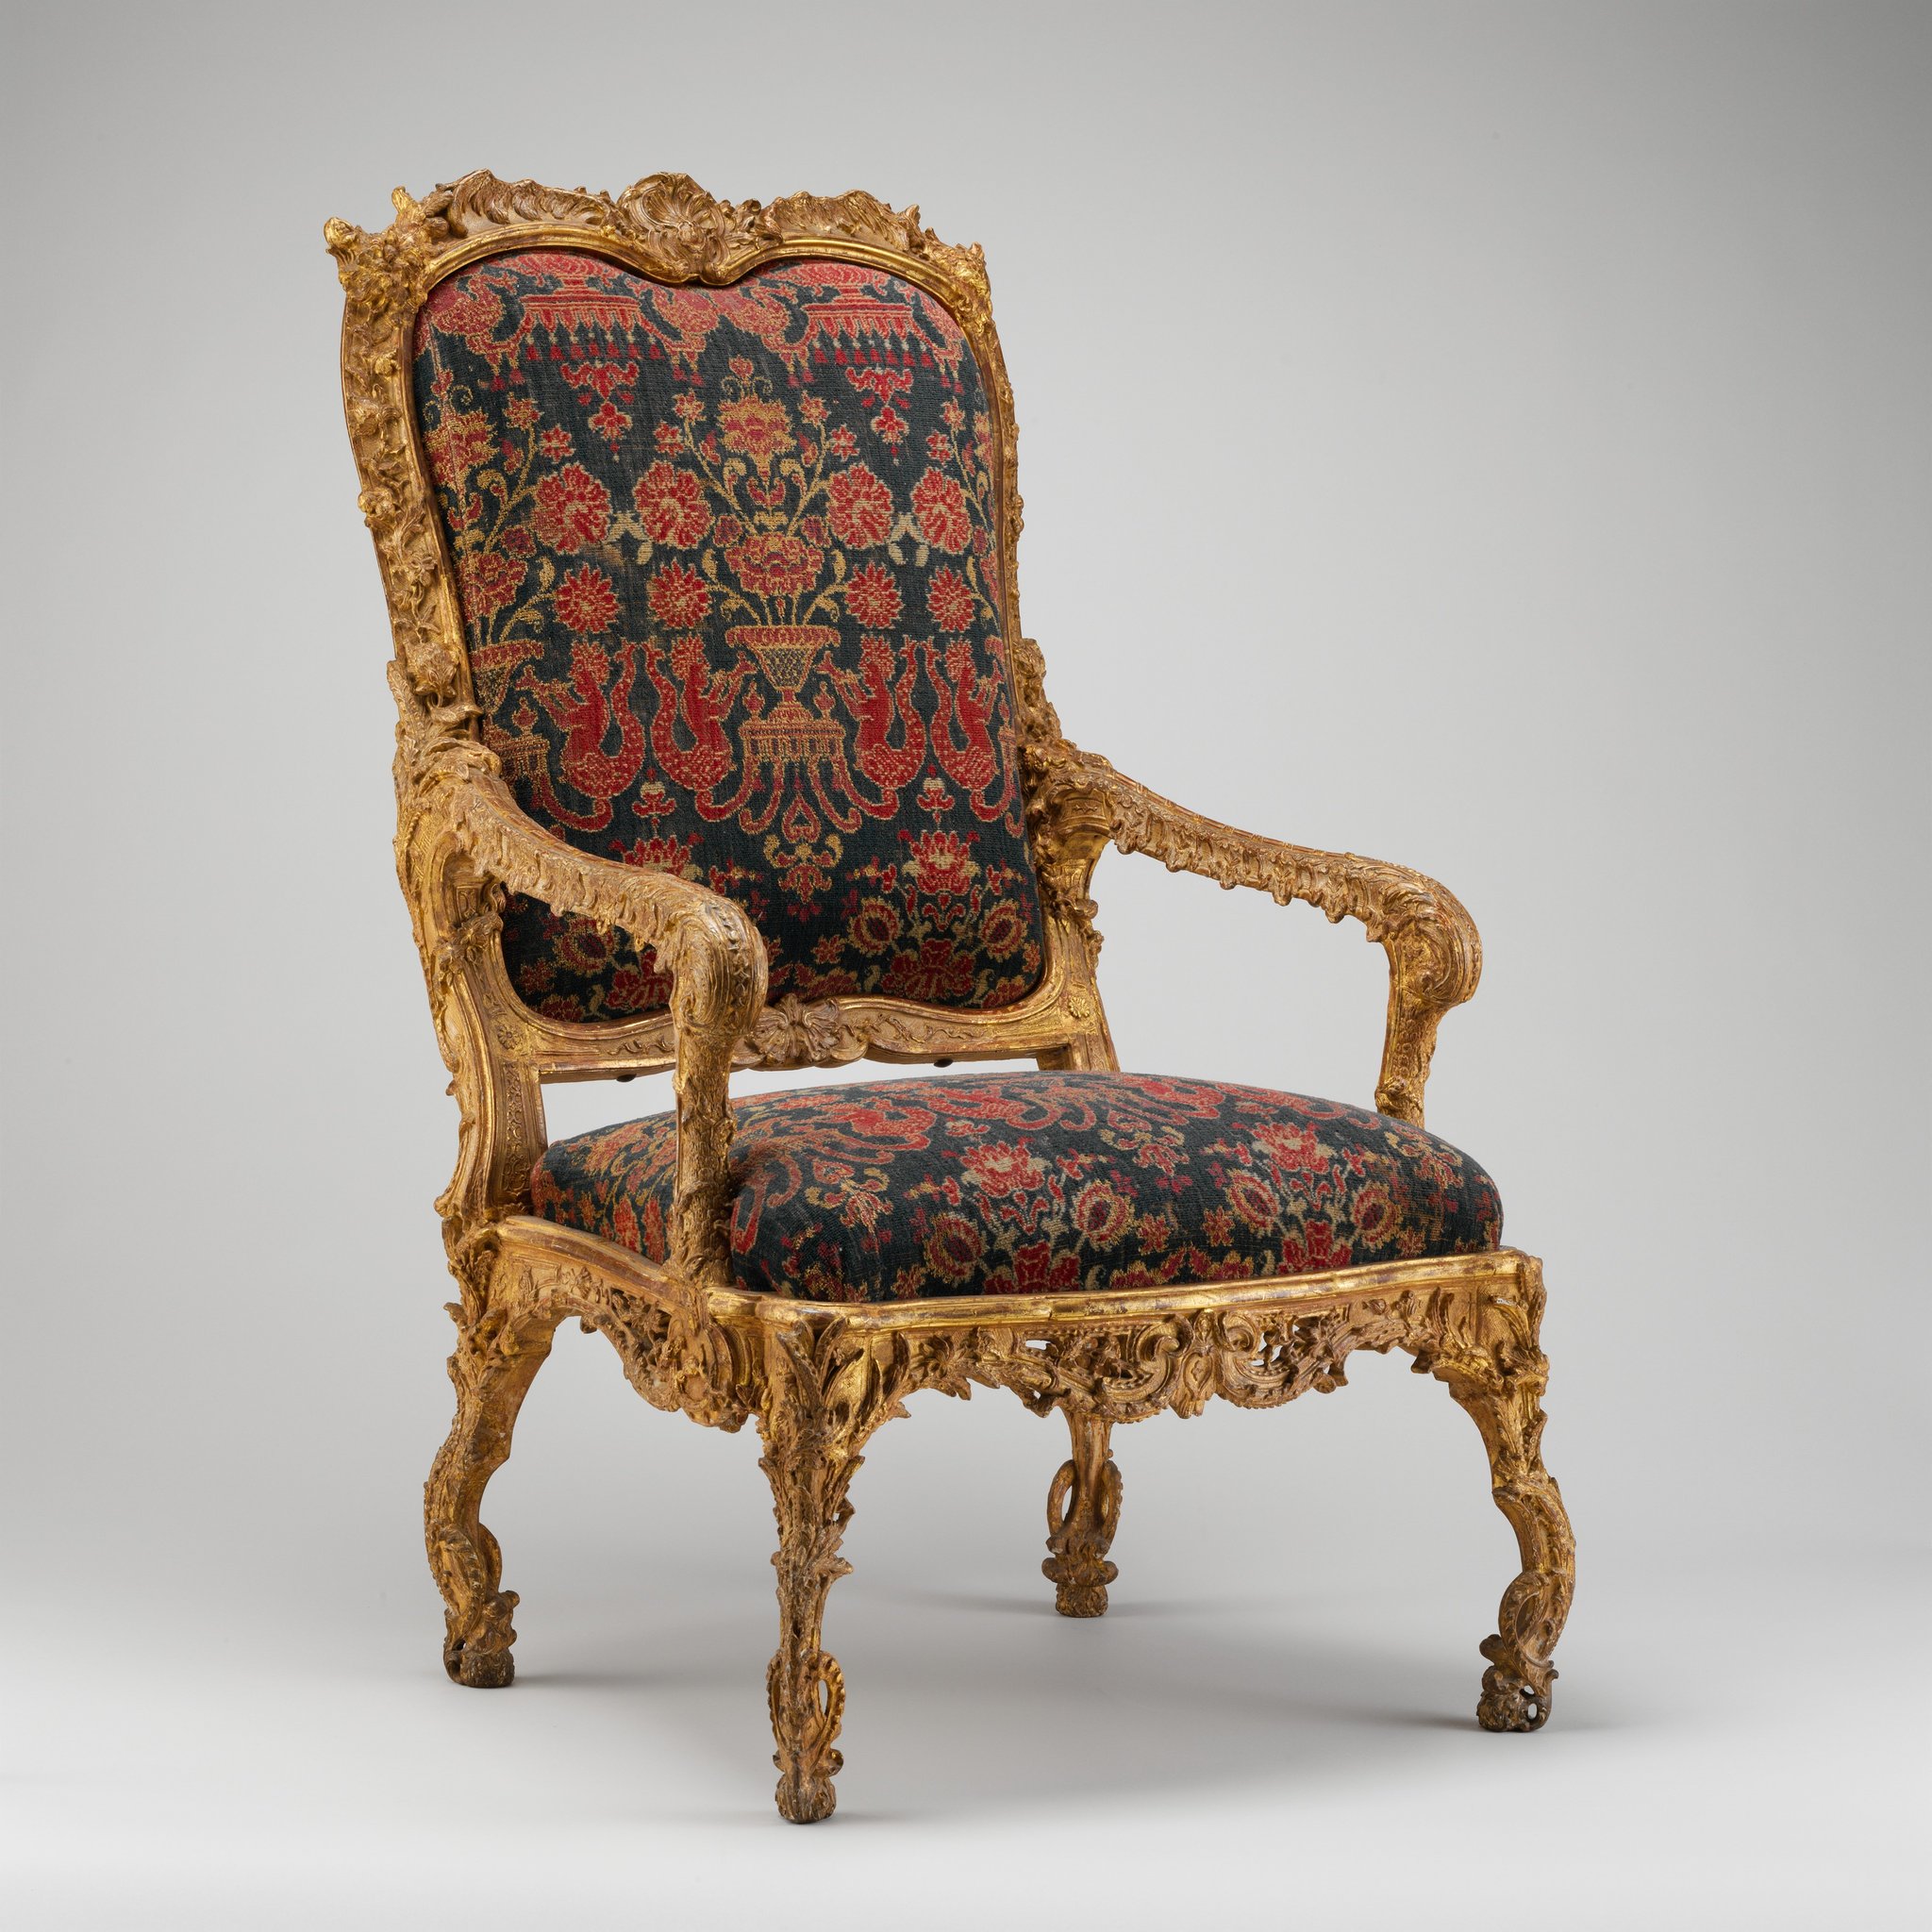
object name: armchair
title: Armchair (fauteuil à la reine)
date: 1690-1710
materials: velvet, wood, wool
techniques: carving, gilding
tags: flowers